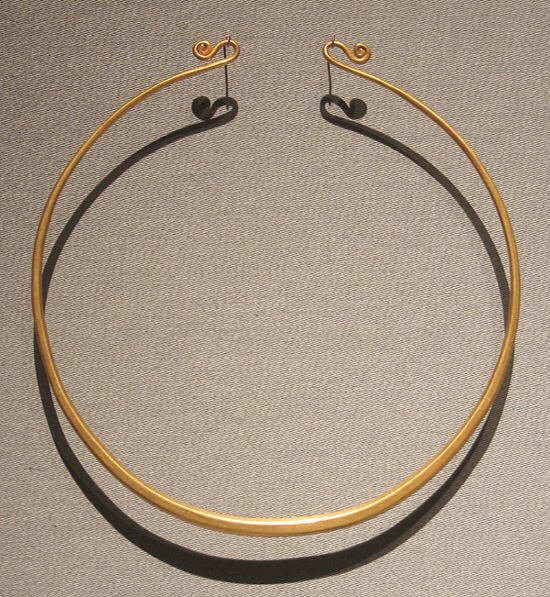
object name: torque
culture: indonesian, javanese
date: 701-833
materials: gold